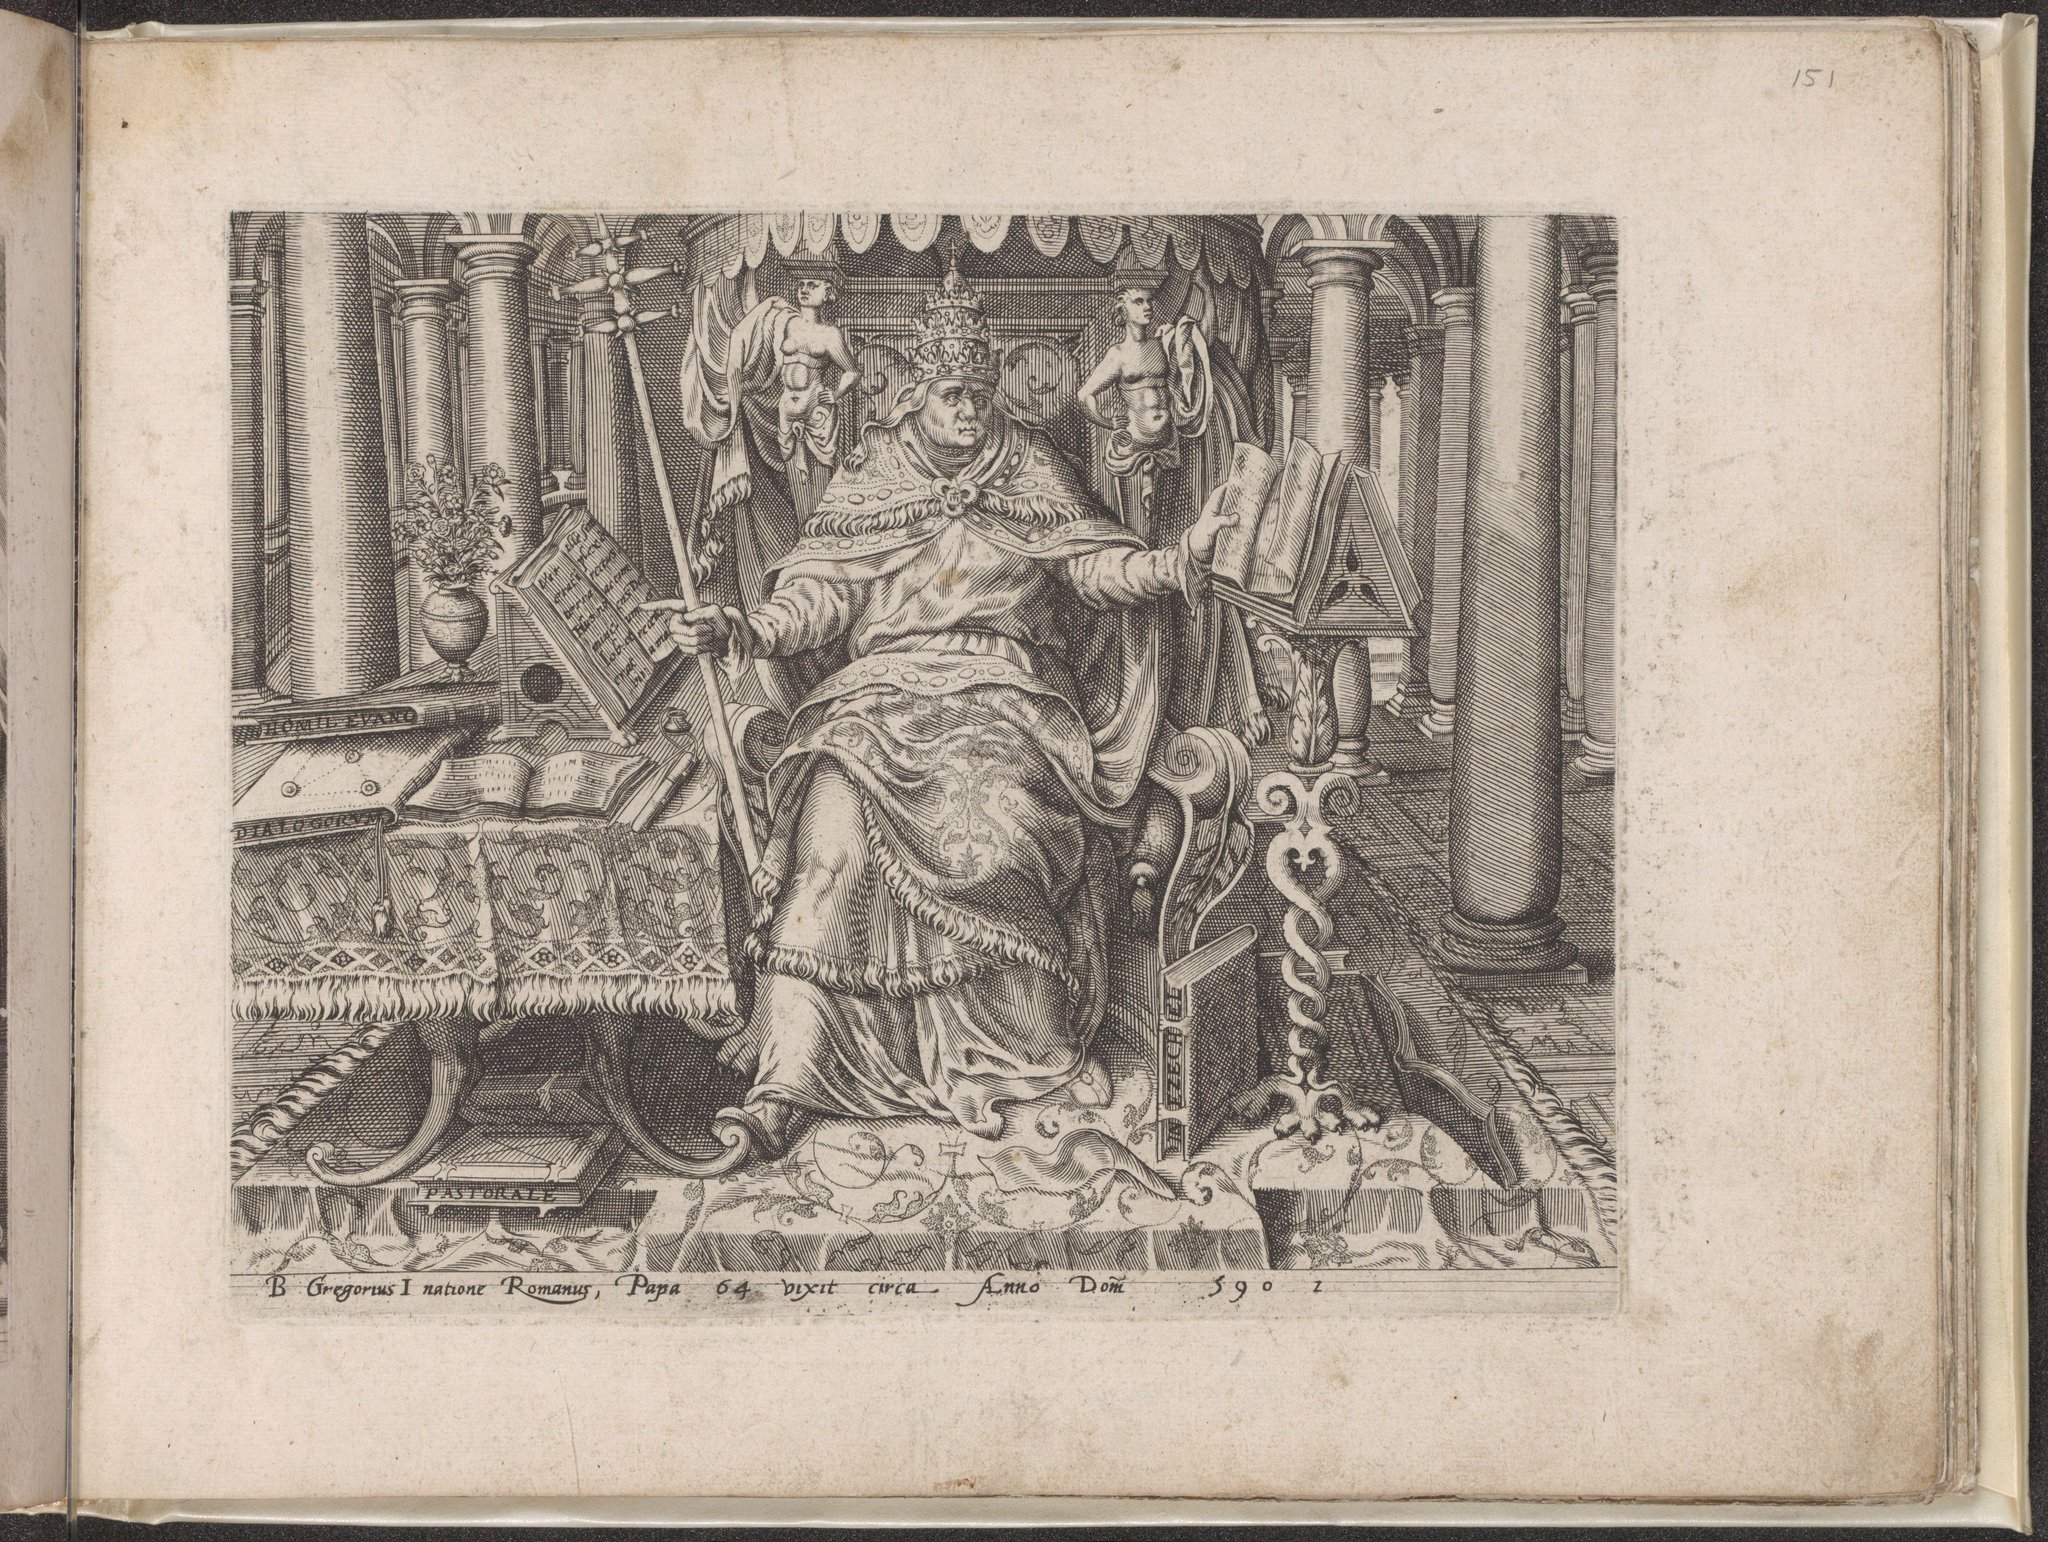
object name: print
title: Kerkvader Gregorius I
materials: paper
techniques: engraving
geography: antwerp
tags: st. gregory the great as doctor of the latin church, with book, pen, and dove (divine inspiration)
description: De H. Gregorius gezeten op een troon. Hij wijst op twee opengeslagen boeken en is gekleed in het pauselijk gewaad met de tiara op zijn hoofd. In zijn rechterhand de pontificale kruisstaf. Onder de voorstelling een verklarende tekst in het Latijn. Deze prent maakt deel uit van een album.